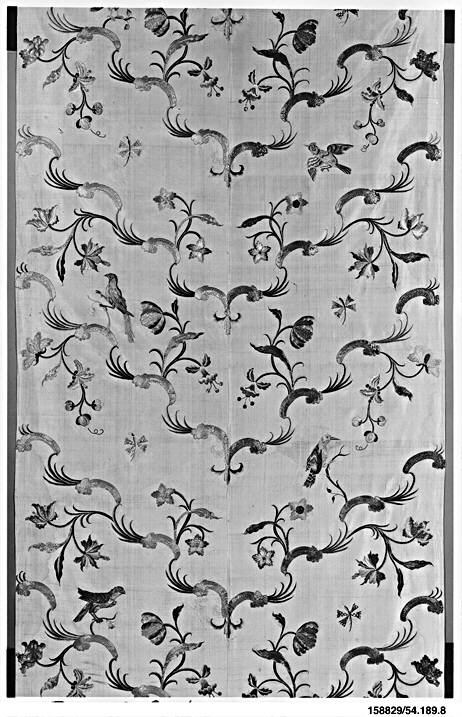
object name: panel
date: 1734-1766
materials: metal thread, silk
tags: birds,flowers